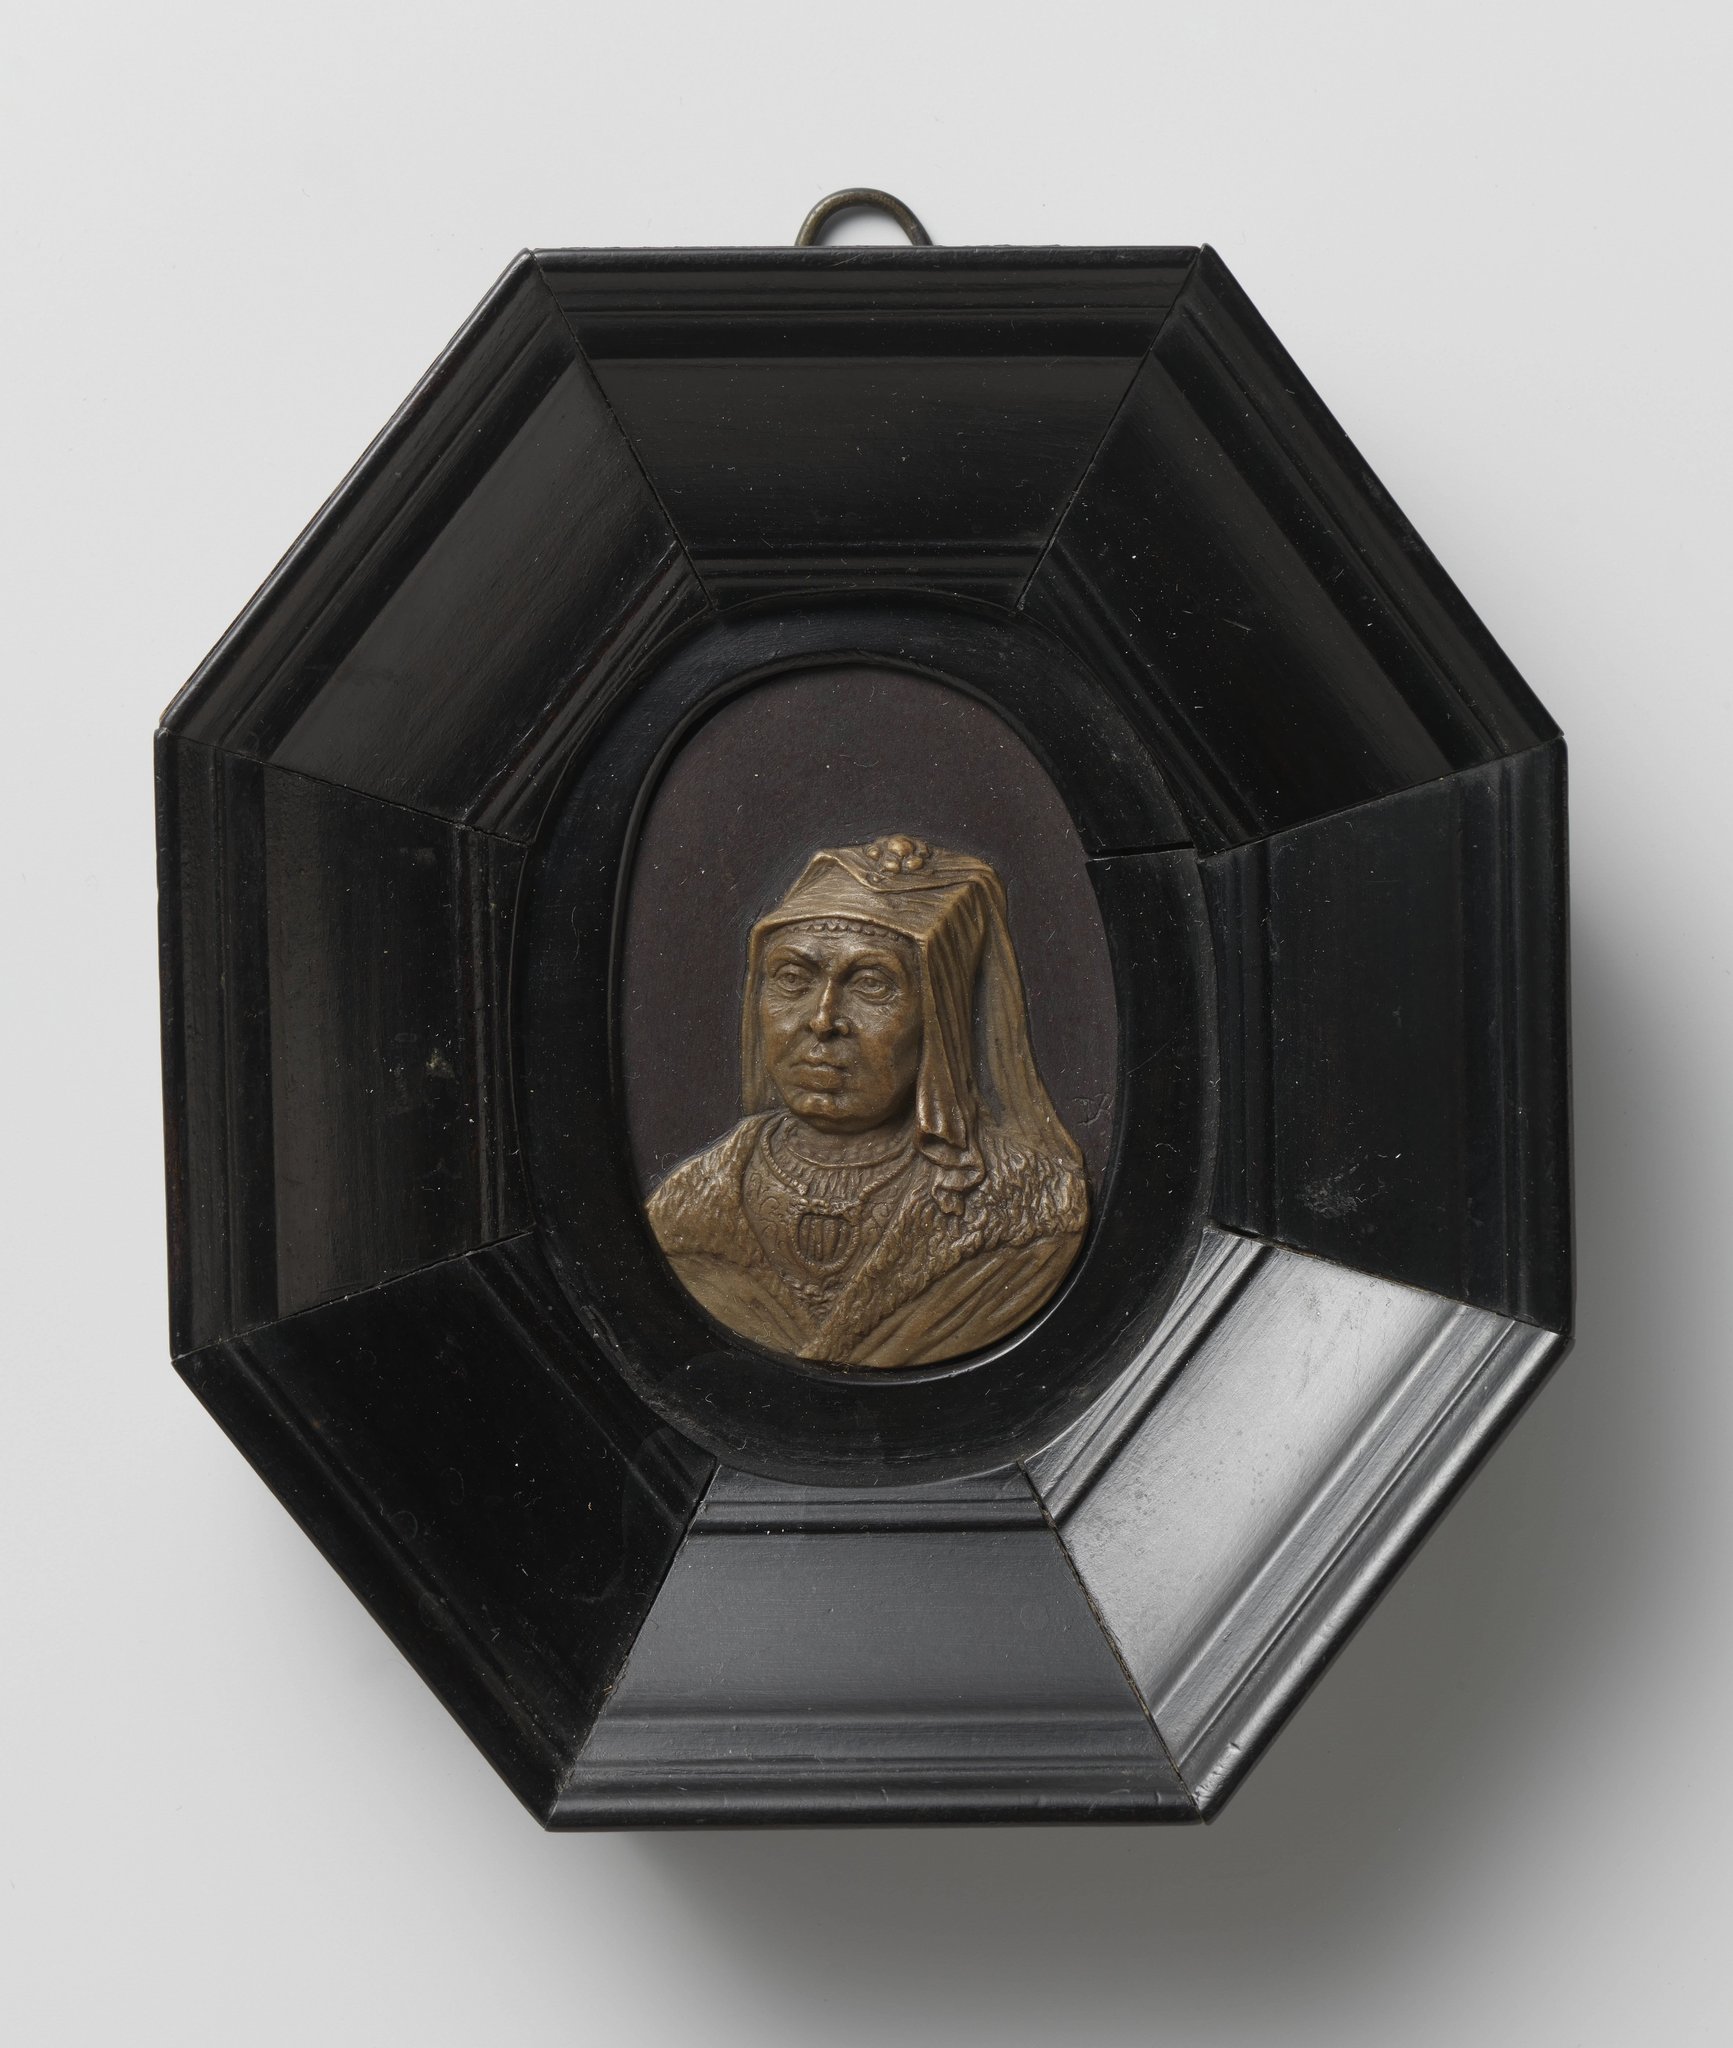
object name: relief sculpture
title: Kenau Simonsdr Hasselaer (1526-1588)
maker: dirk van rijswijck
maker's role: medailleur, paarlemoerinlegger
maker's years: 1596-1679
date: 1650-1675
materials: wood, stone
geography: amsterdam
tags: haarlem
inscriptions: monogram, above the sitter’s left shoulder, incised: ‘DVR’, inscription, on a label on the reverse, in late-18th/early-19th century handwriting: ‘Kenau Simonsdr. Hasselaar, geb. te Haarlem 1526 overl. aldaar tusschen St. Jansdag 1588 en 23 July 1589’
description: Borstbeeld in reliëf van Kenau Simonsdr. Hasselaer, echtgenote van Nanning Gerbrandsz. Borst. Zij is driekwart naar links gewend, geplaatst tegen een ovele vlakke achtergrond en gekleed in pseudo-renaissance kostuum. Zij draagt een huif, waarvan de lobben boven het voorhoofd juist te zien zijn, en een sluier, waarboven zich weer een naar achteren afhangende doek bevindt, die met een broche daaraan is bevestigd. Voorts een geplooid hemd over een met ranken versierd gewaad, waarvan het split bovenaan is samengesnoerd en een mantel met grote platte bontkraag, waaronder een ketting even zichtbaar is. Boven haar linker schouder het monogram DVR. In een achzijdig ebbenhouten lijstje.